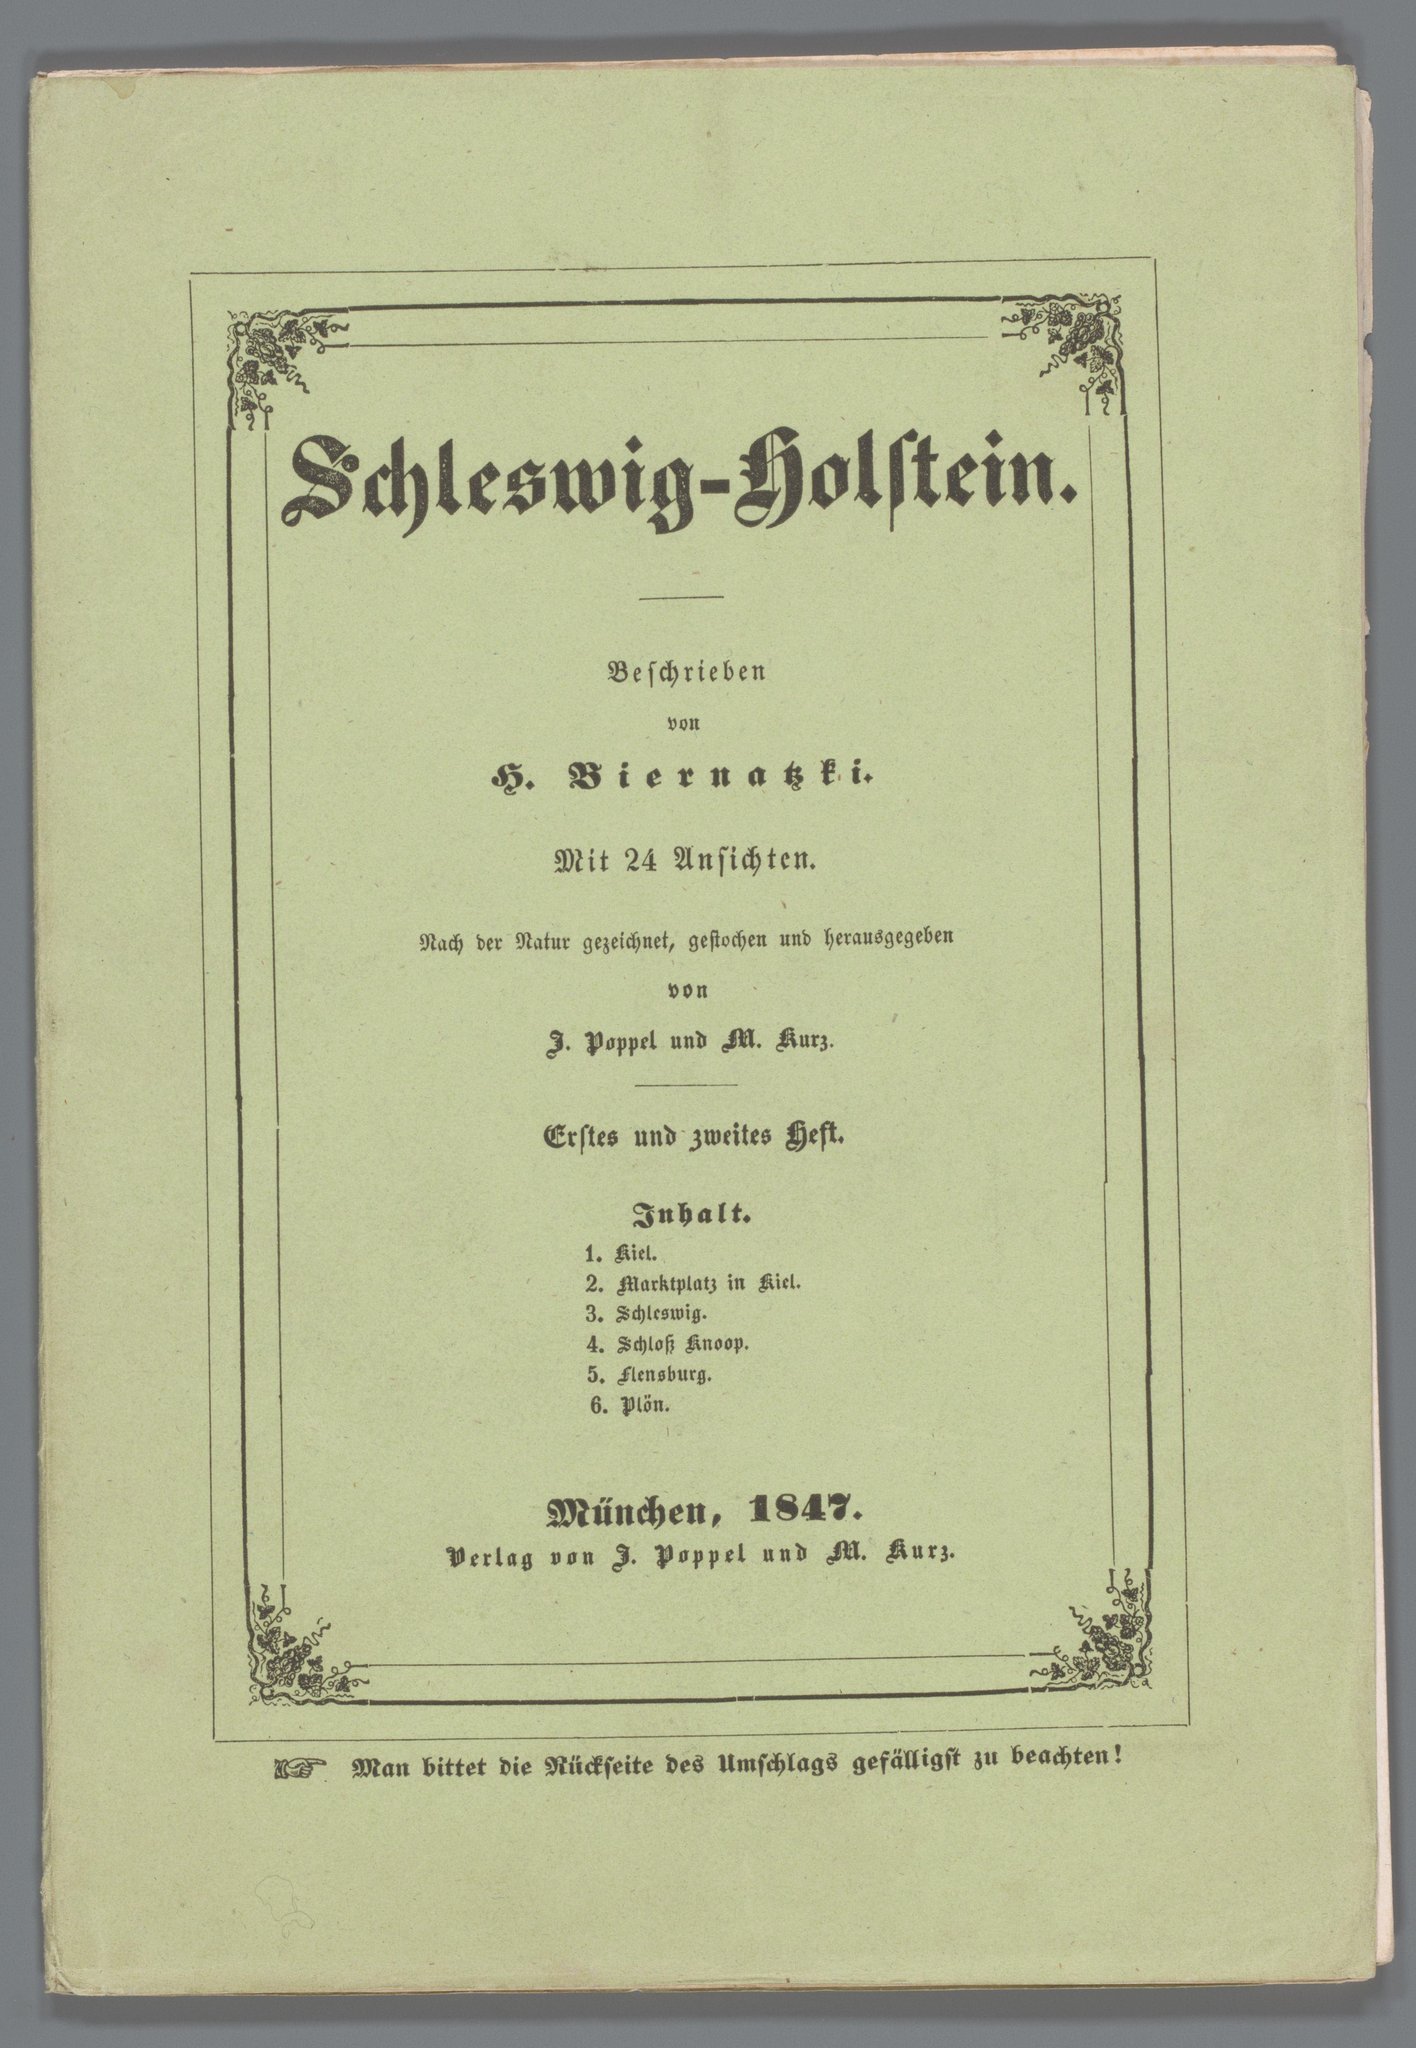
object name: wrapper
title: Landschappen in Sleeswijk-Holstein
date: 1847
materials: paper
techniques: etching, letterpress printing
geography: munich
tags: low hill country (+ landscape with figures, staffage), prospect of city, town panorama, silhouette of city (+ city(-scape) with figures, staffage)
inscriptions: date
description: Onderdeel van een vierdelige reeks uitgegeven in twee omslagen waarvan deze omslag deel één en twee bevat met daarin zes landschappen en zeven tekstbladen. Mogelijk bevat de complete uitgave, zoals aangegeven op de omslag, 24 prenten, echter is de gedrukte inhoudsopgave wel coherent met de inhoud van de aanwezige zes prenten.